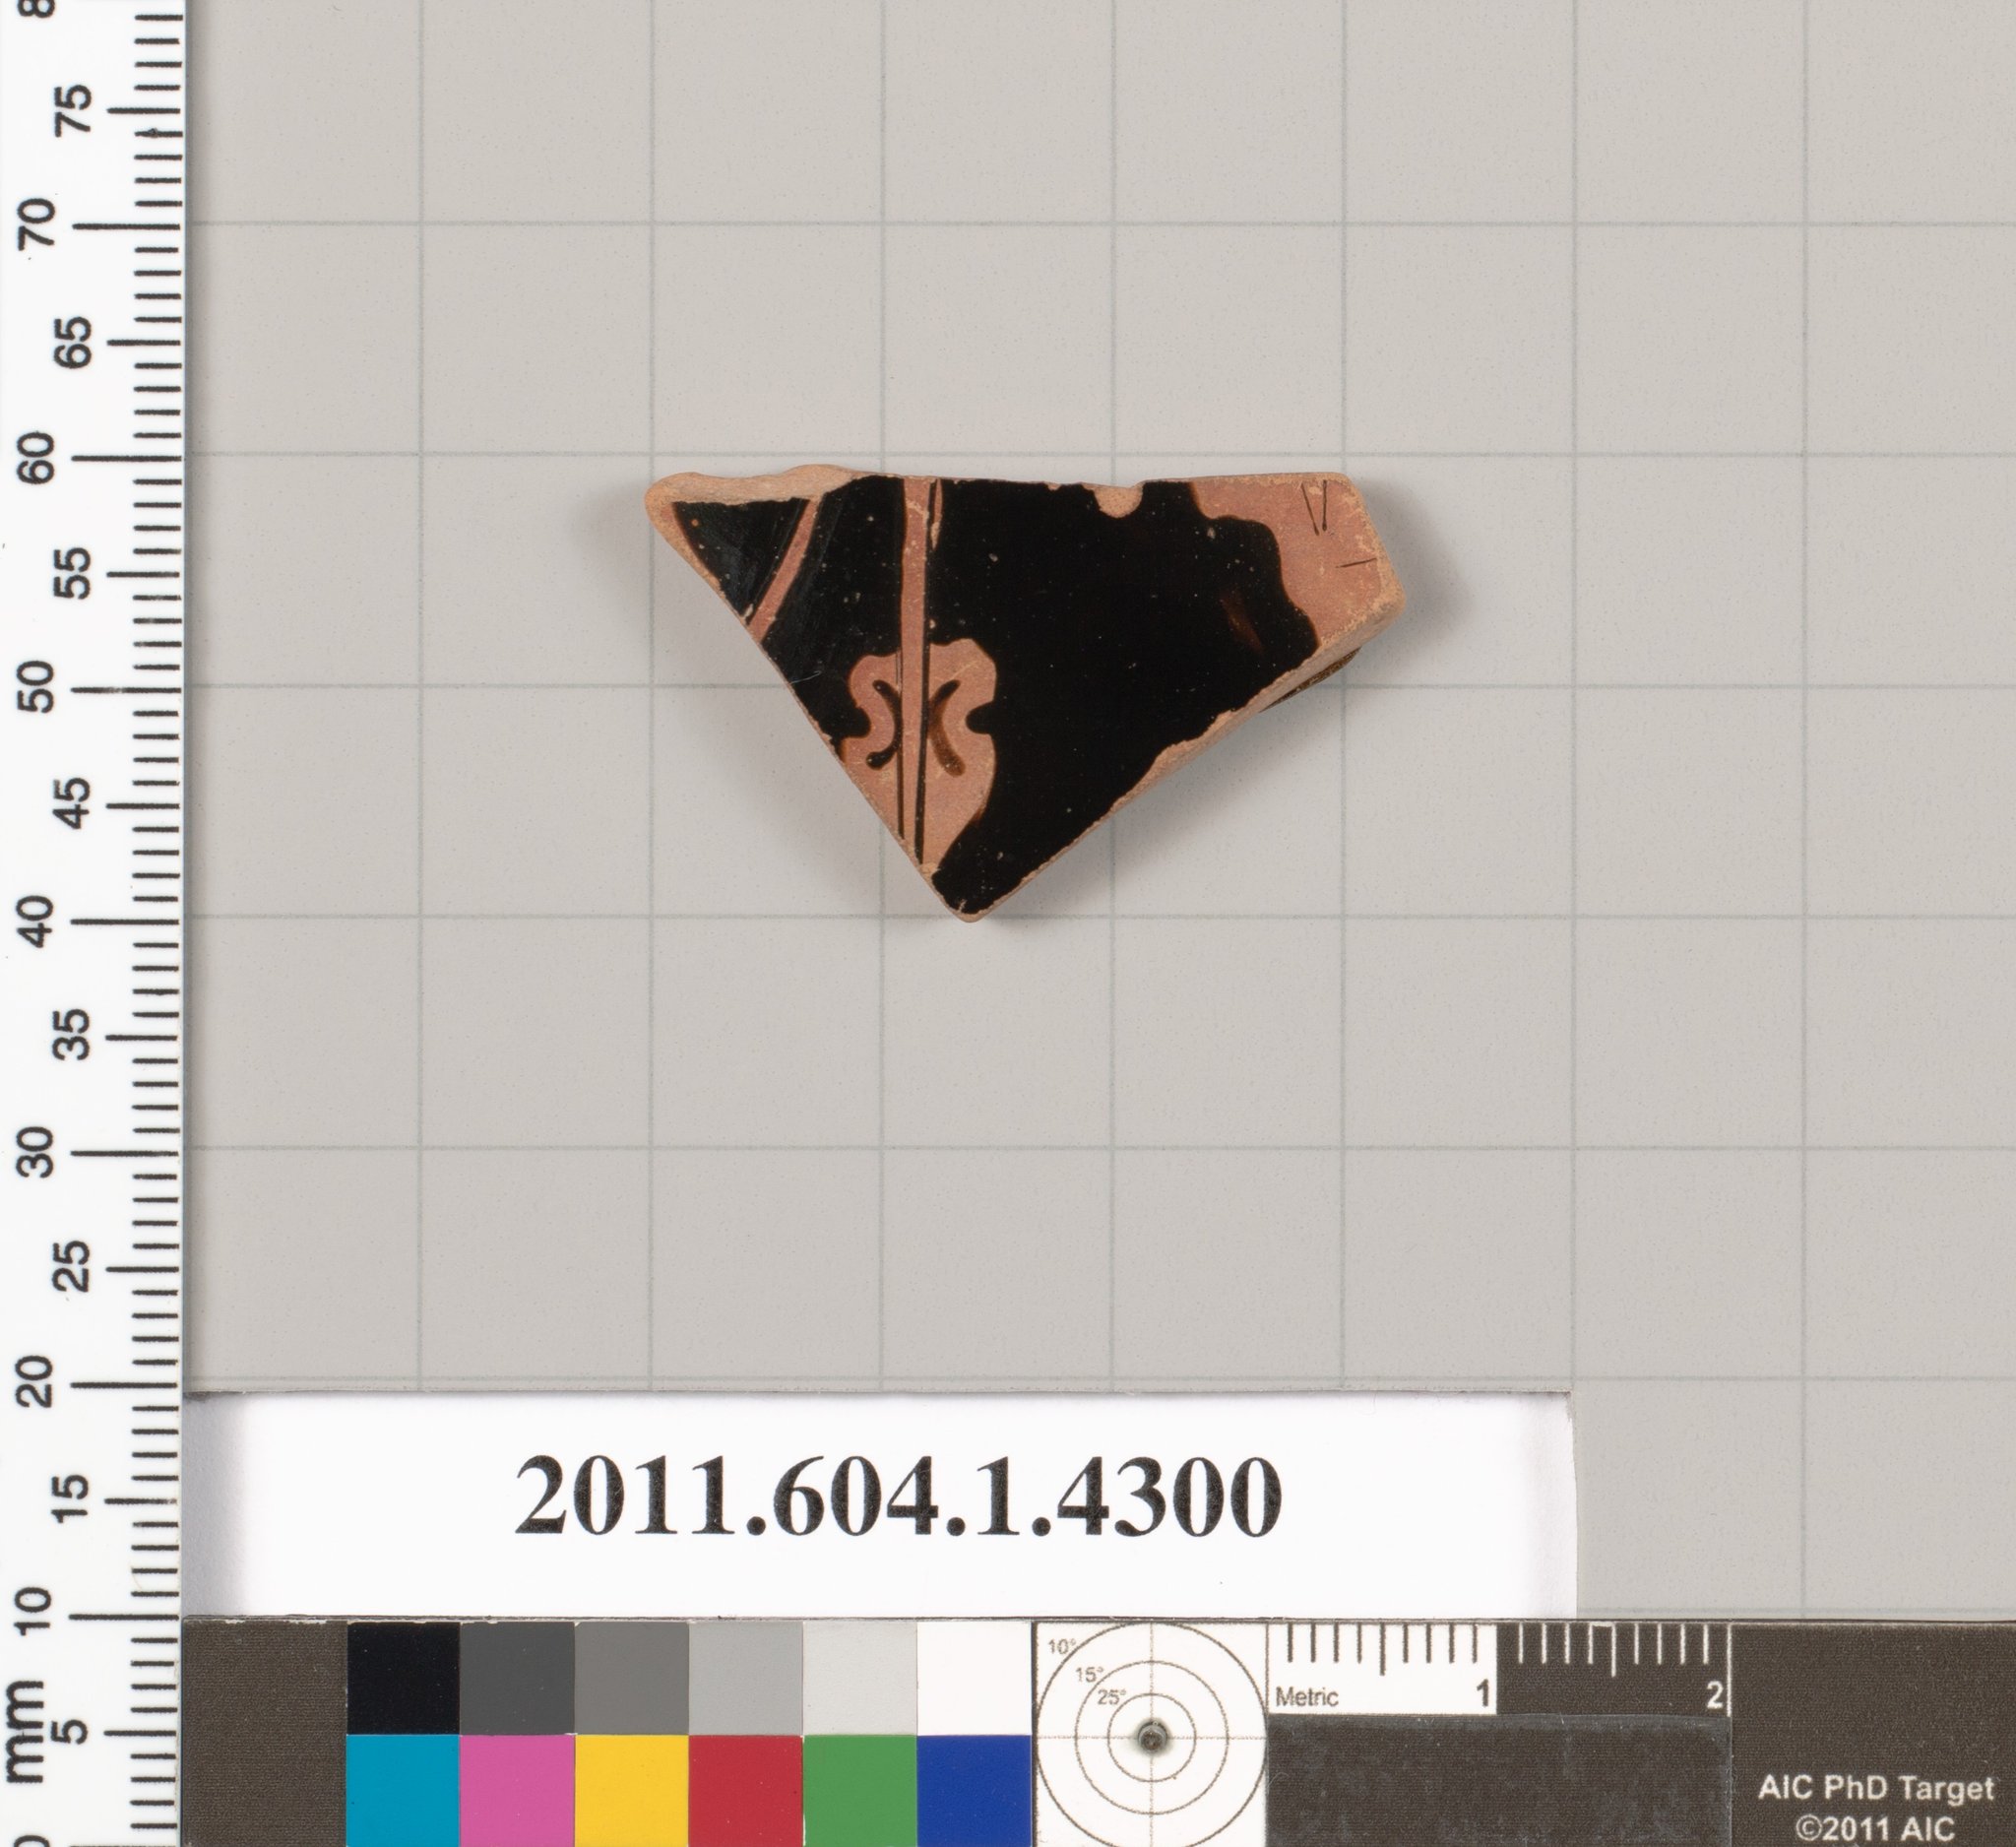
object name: kylix fragment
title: Terracotta fragment of a kylix (drinking cup)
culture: greek, attic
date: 475-451 BCE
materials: terracotta